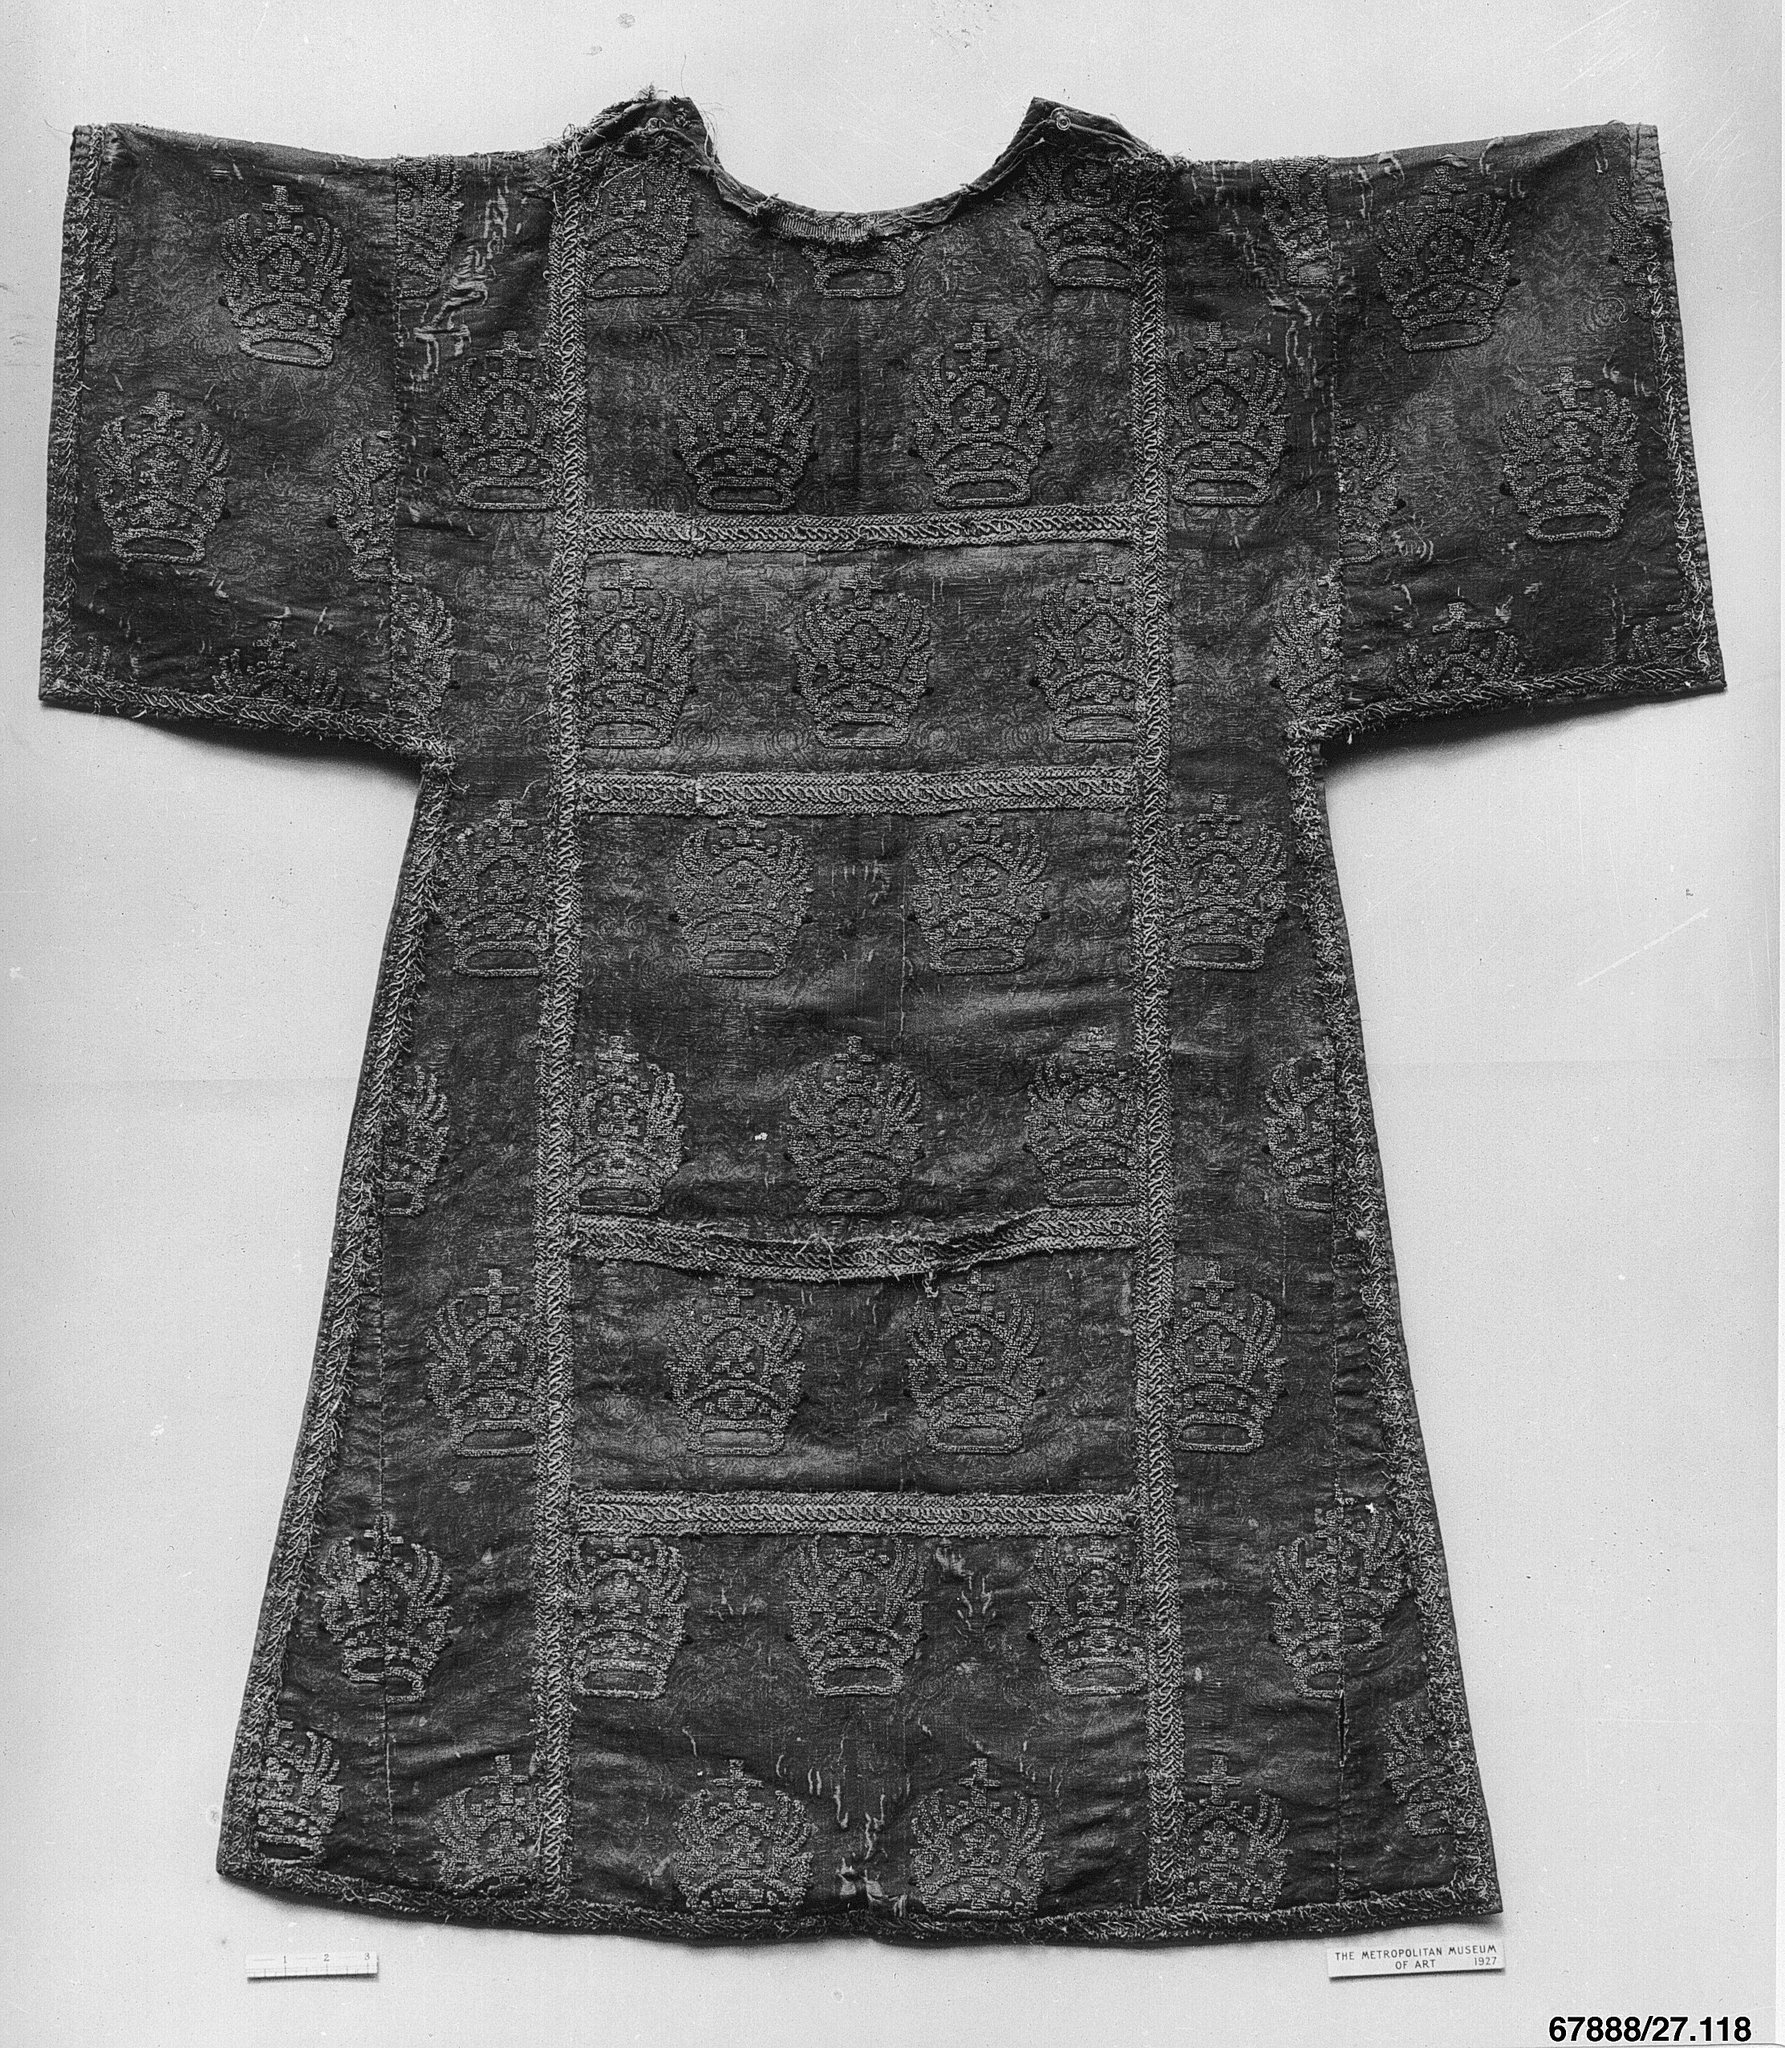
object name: dalmatic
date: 1534-1566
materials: metal thread, silk